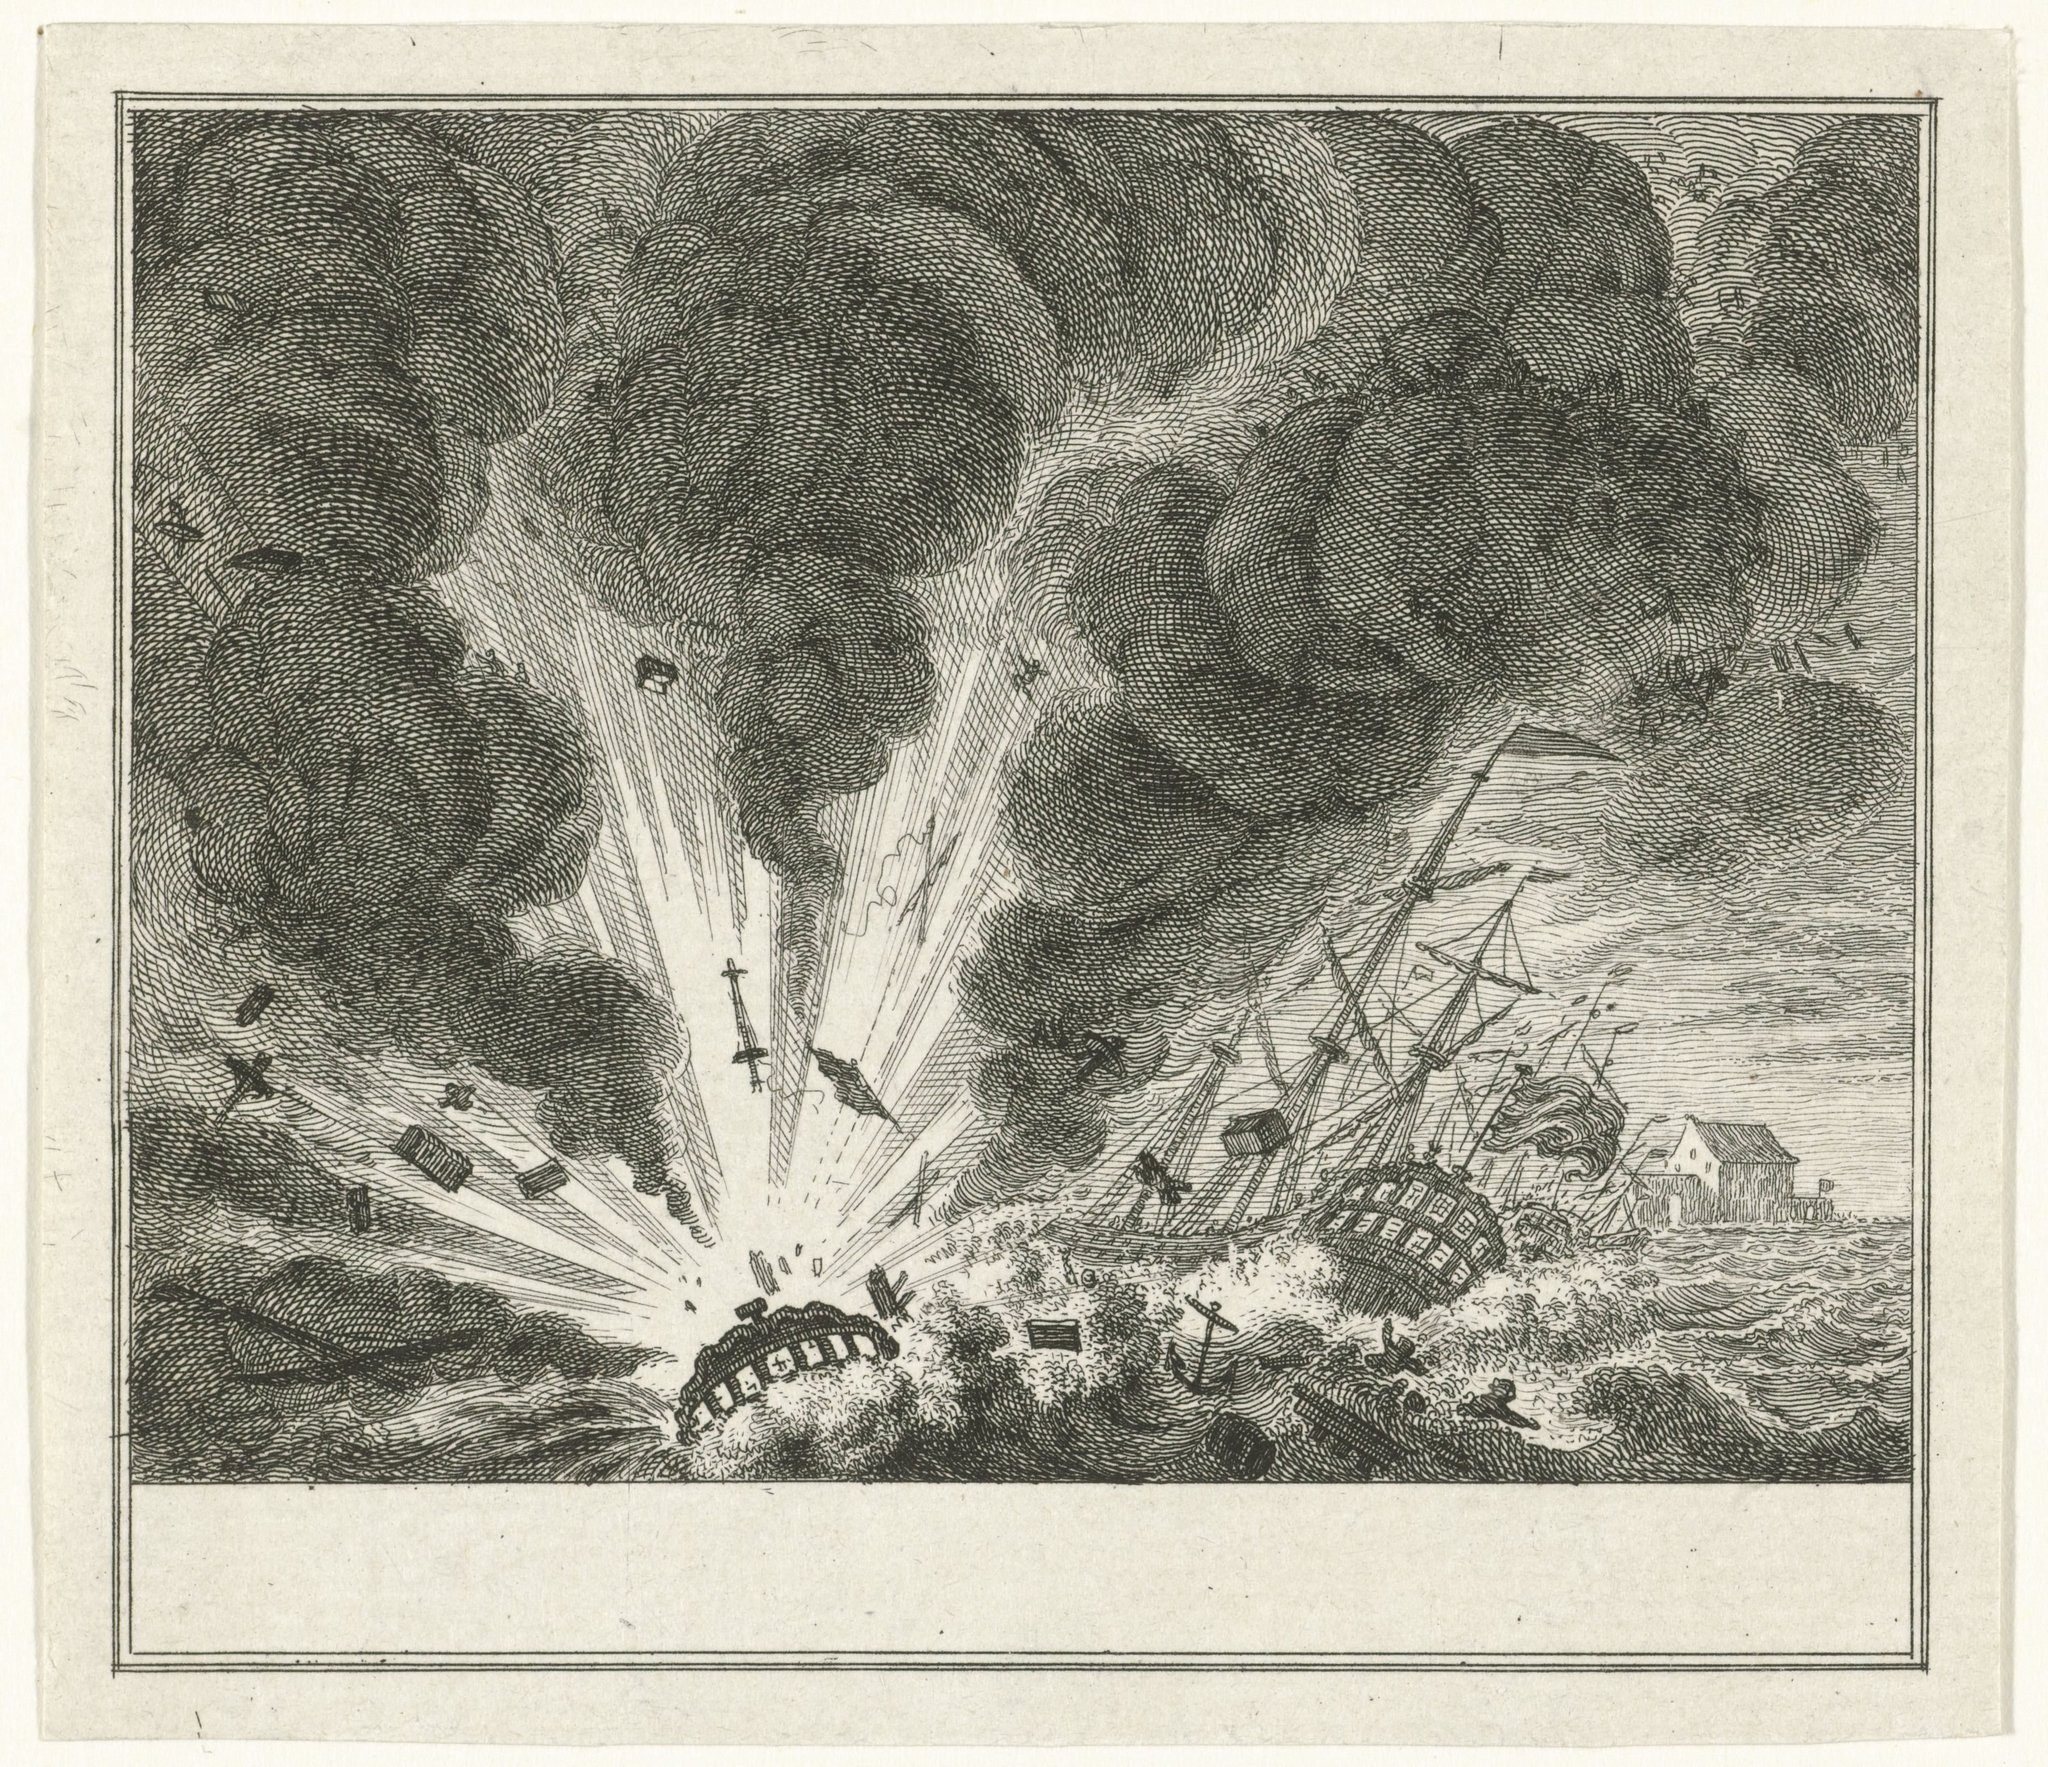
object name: print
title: Ontploffen van het oorlogsschip Alphen in de haven van Curaçao, 1778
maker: simon fokke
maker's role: draughtsman, print maker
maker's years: 1712-1784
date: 1778-1779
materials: paper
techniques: engraving, etching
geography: northern netherlands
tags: gunpowder disaster (+ sailing-ships)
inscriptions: collector's mark: Lugt 2228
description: Het ontploffen van het fregat Alphen met de volledige bemanning van 206 man in de haven van Willemstad aan de St. Annabaai te Curaçao, 15 september 1778. Een explosie rijt het schip in stukken.